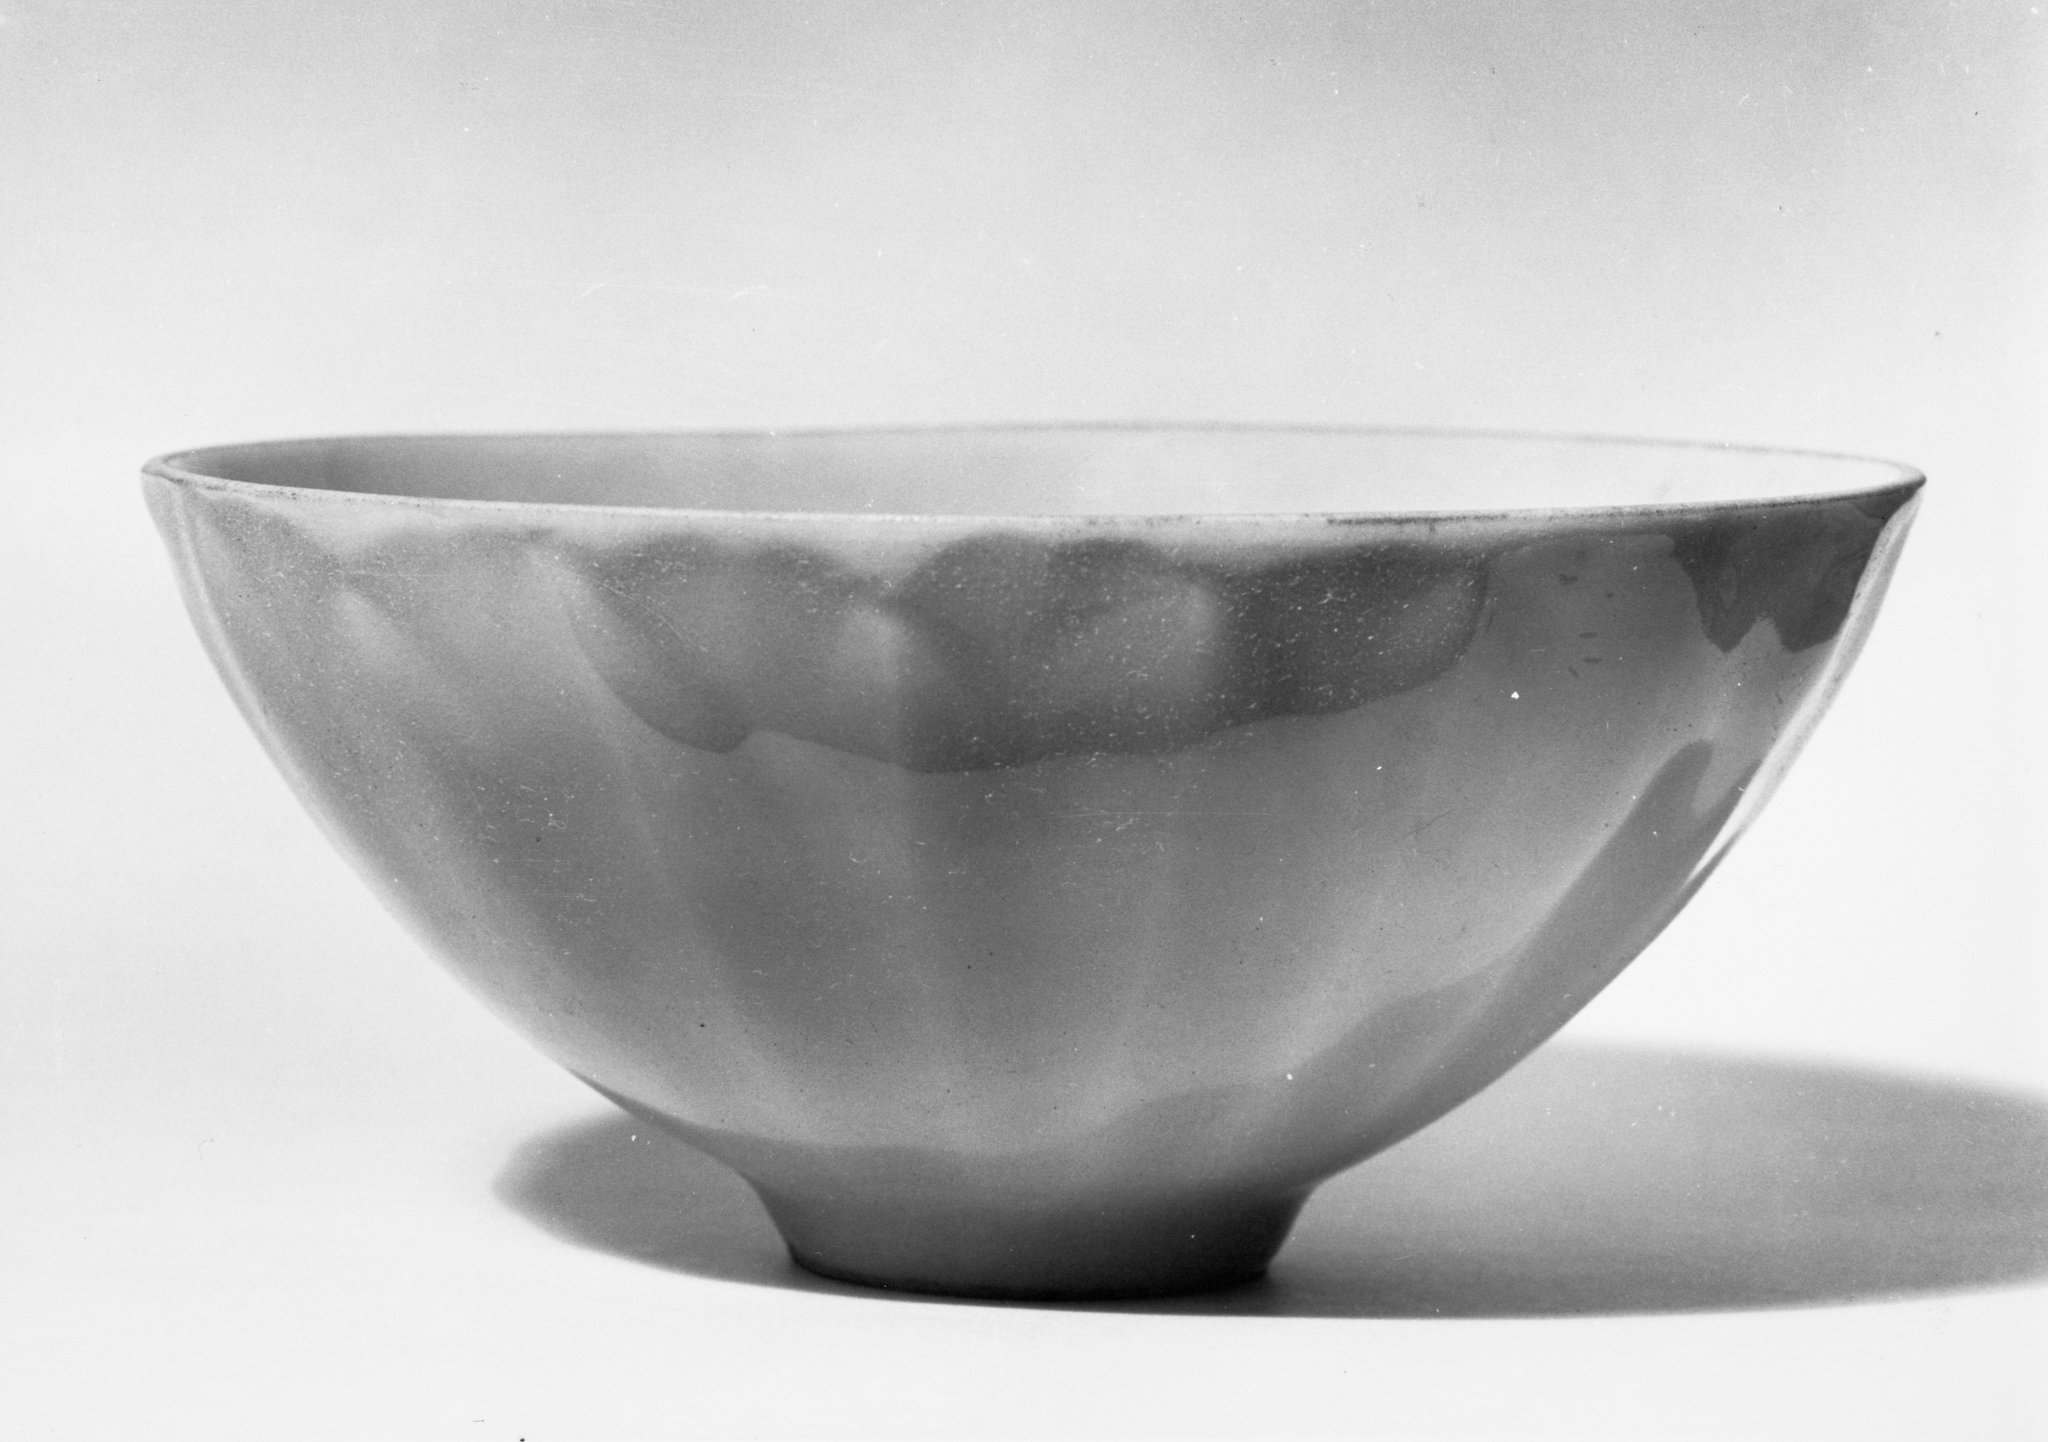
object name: bowl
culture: chinese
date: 1101-1300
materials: ceramic glaze, glaze, stoneware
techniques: relief